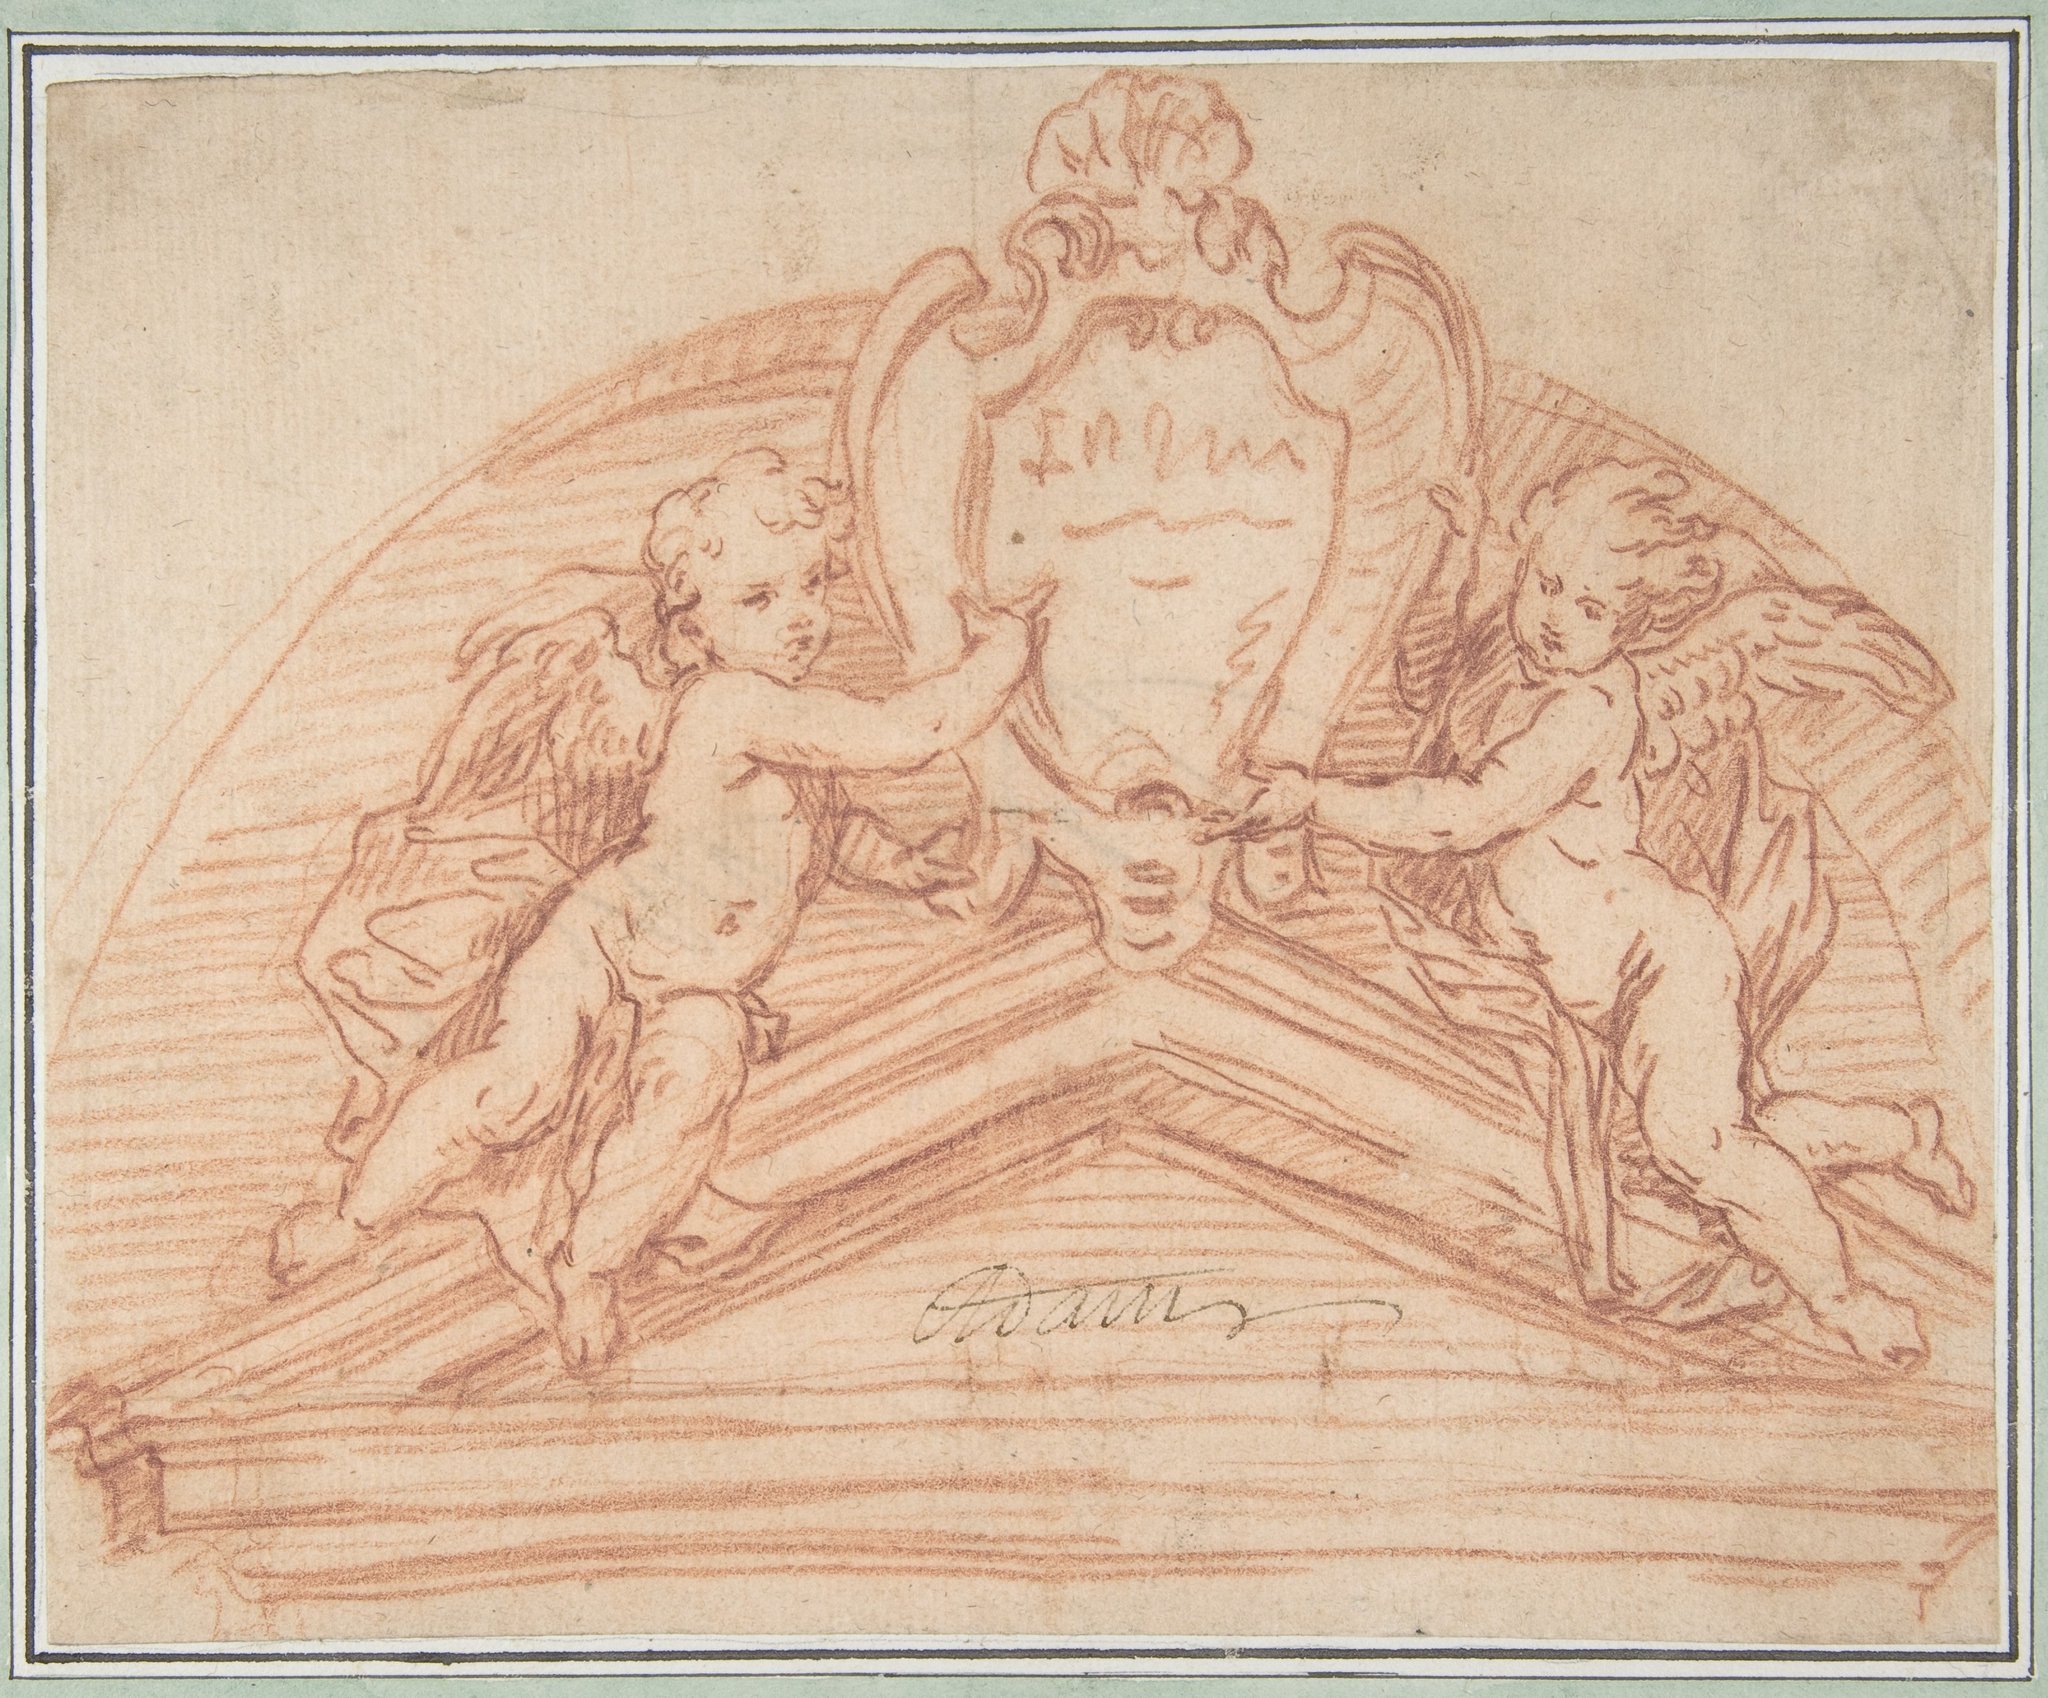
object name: drawing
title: Design for a Pediment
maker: anonymous, french, 18th century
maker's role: artist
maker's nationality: french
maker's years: 1700-1800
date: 1701-1800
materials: chalk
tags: putti